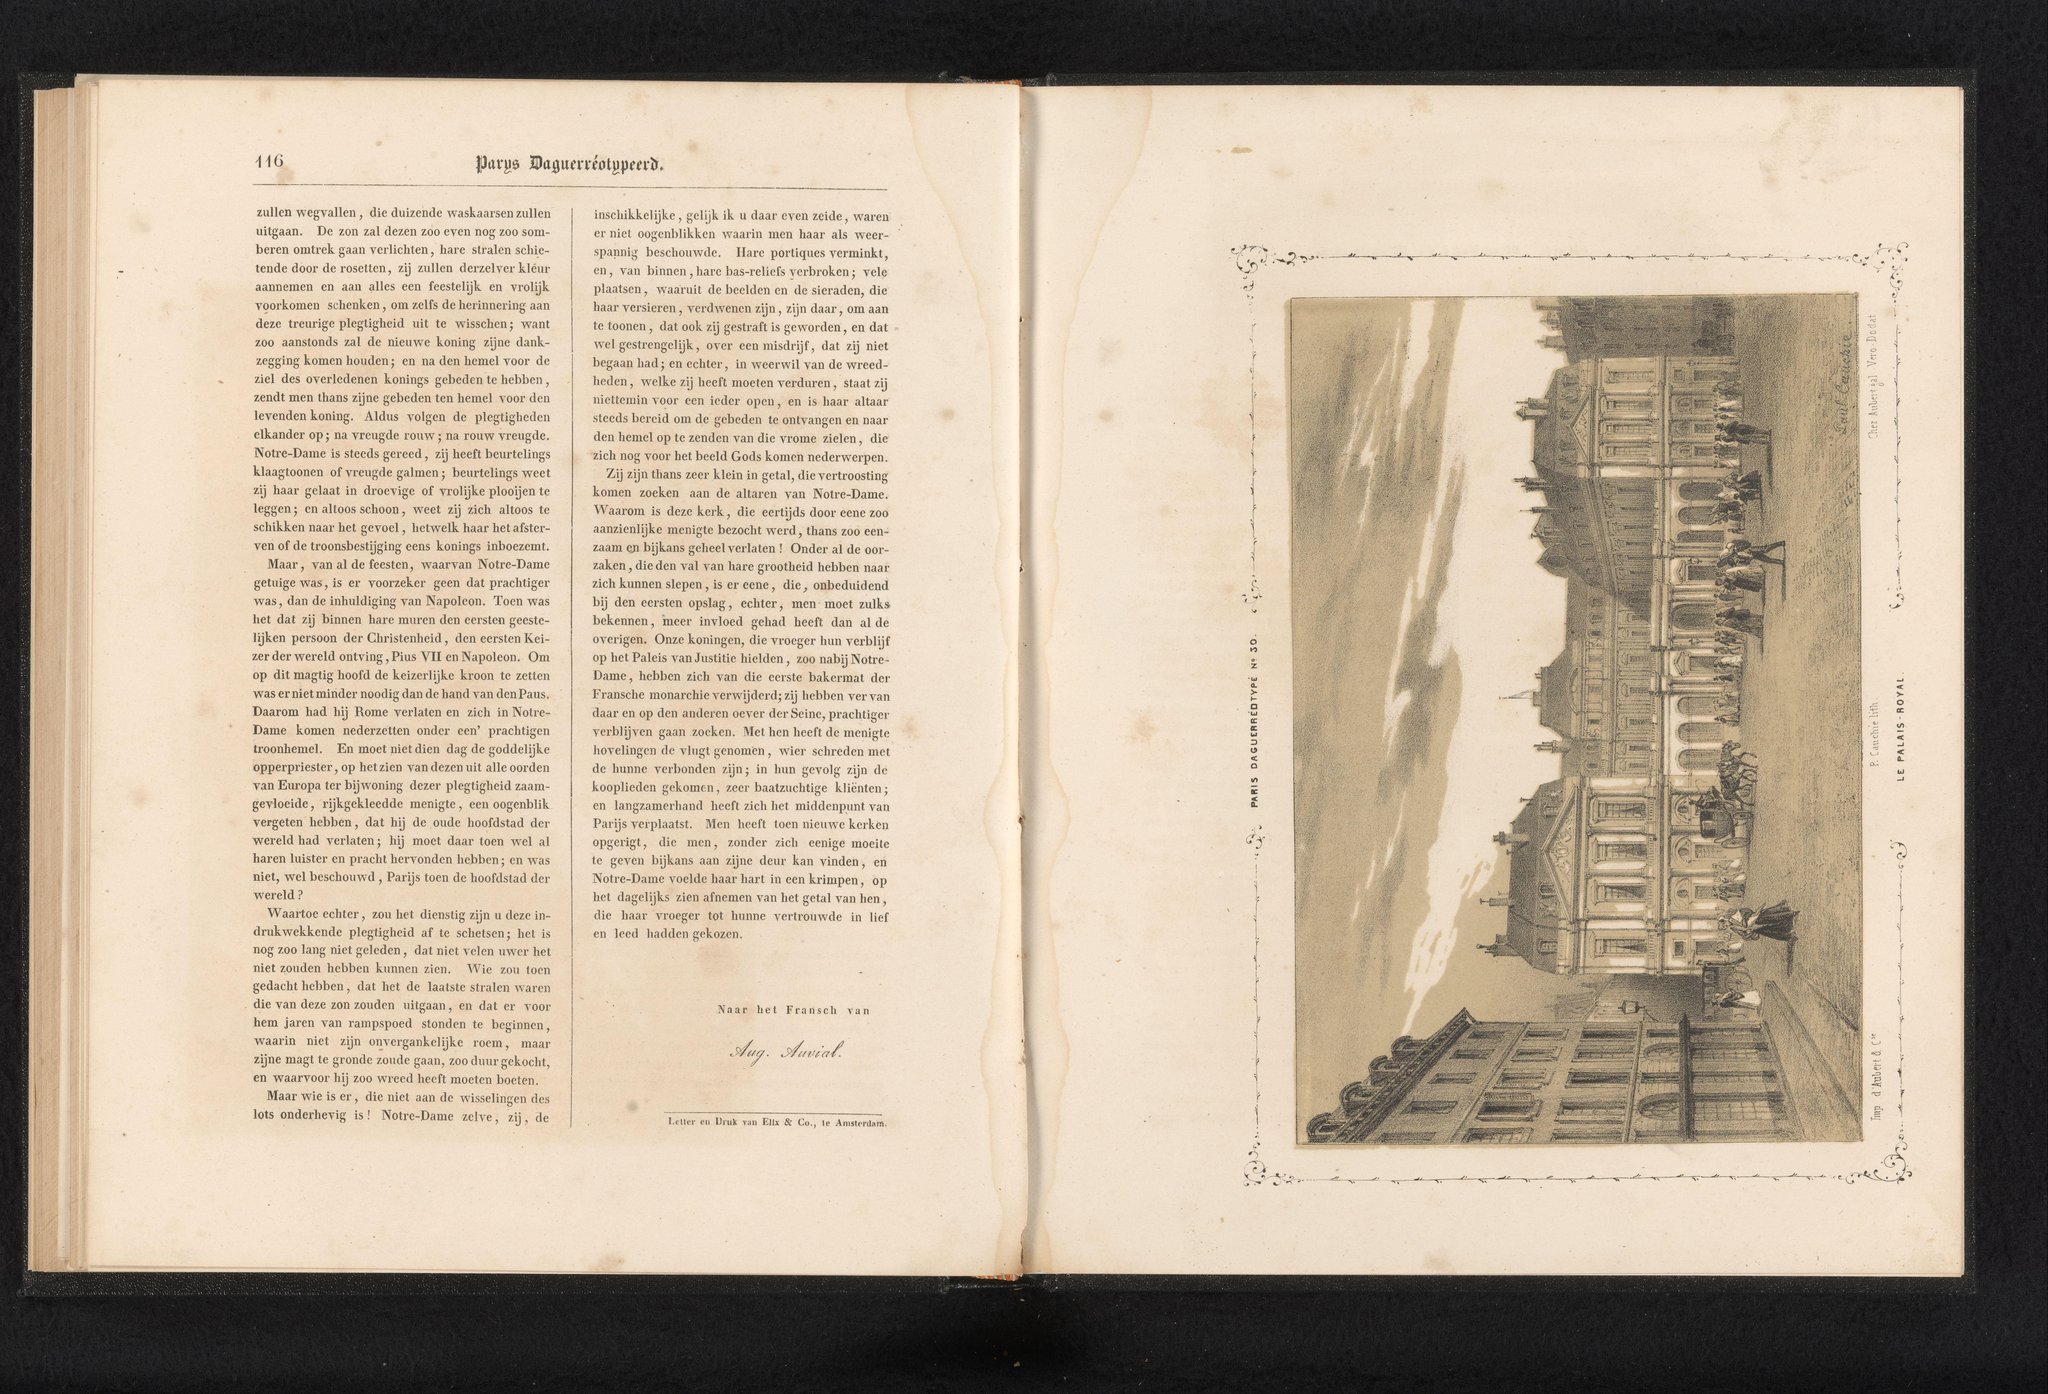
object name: print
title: Le Palais-Royal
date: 1839-1840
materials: paper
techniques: tone lithography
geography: paris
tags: palace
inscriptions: inscription: ‘PARIS DAGUERRÉOTYPÉ No. 30.’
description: Prent op honderdnegentiende ongenummerde pagina.